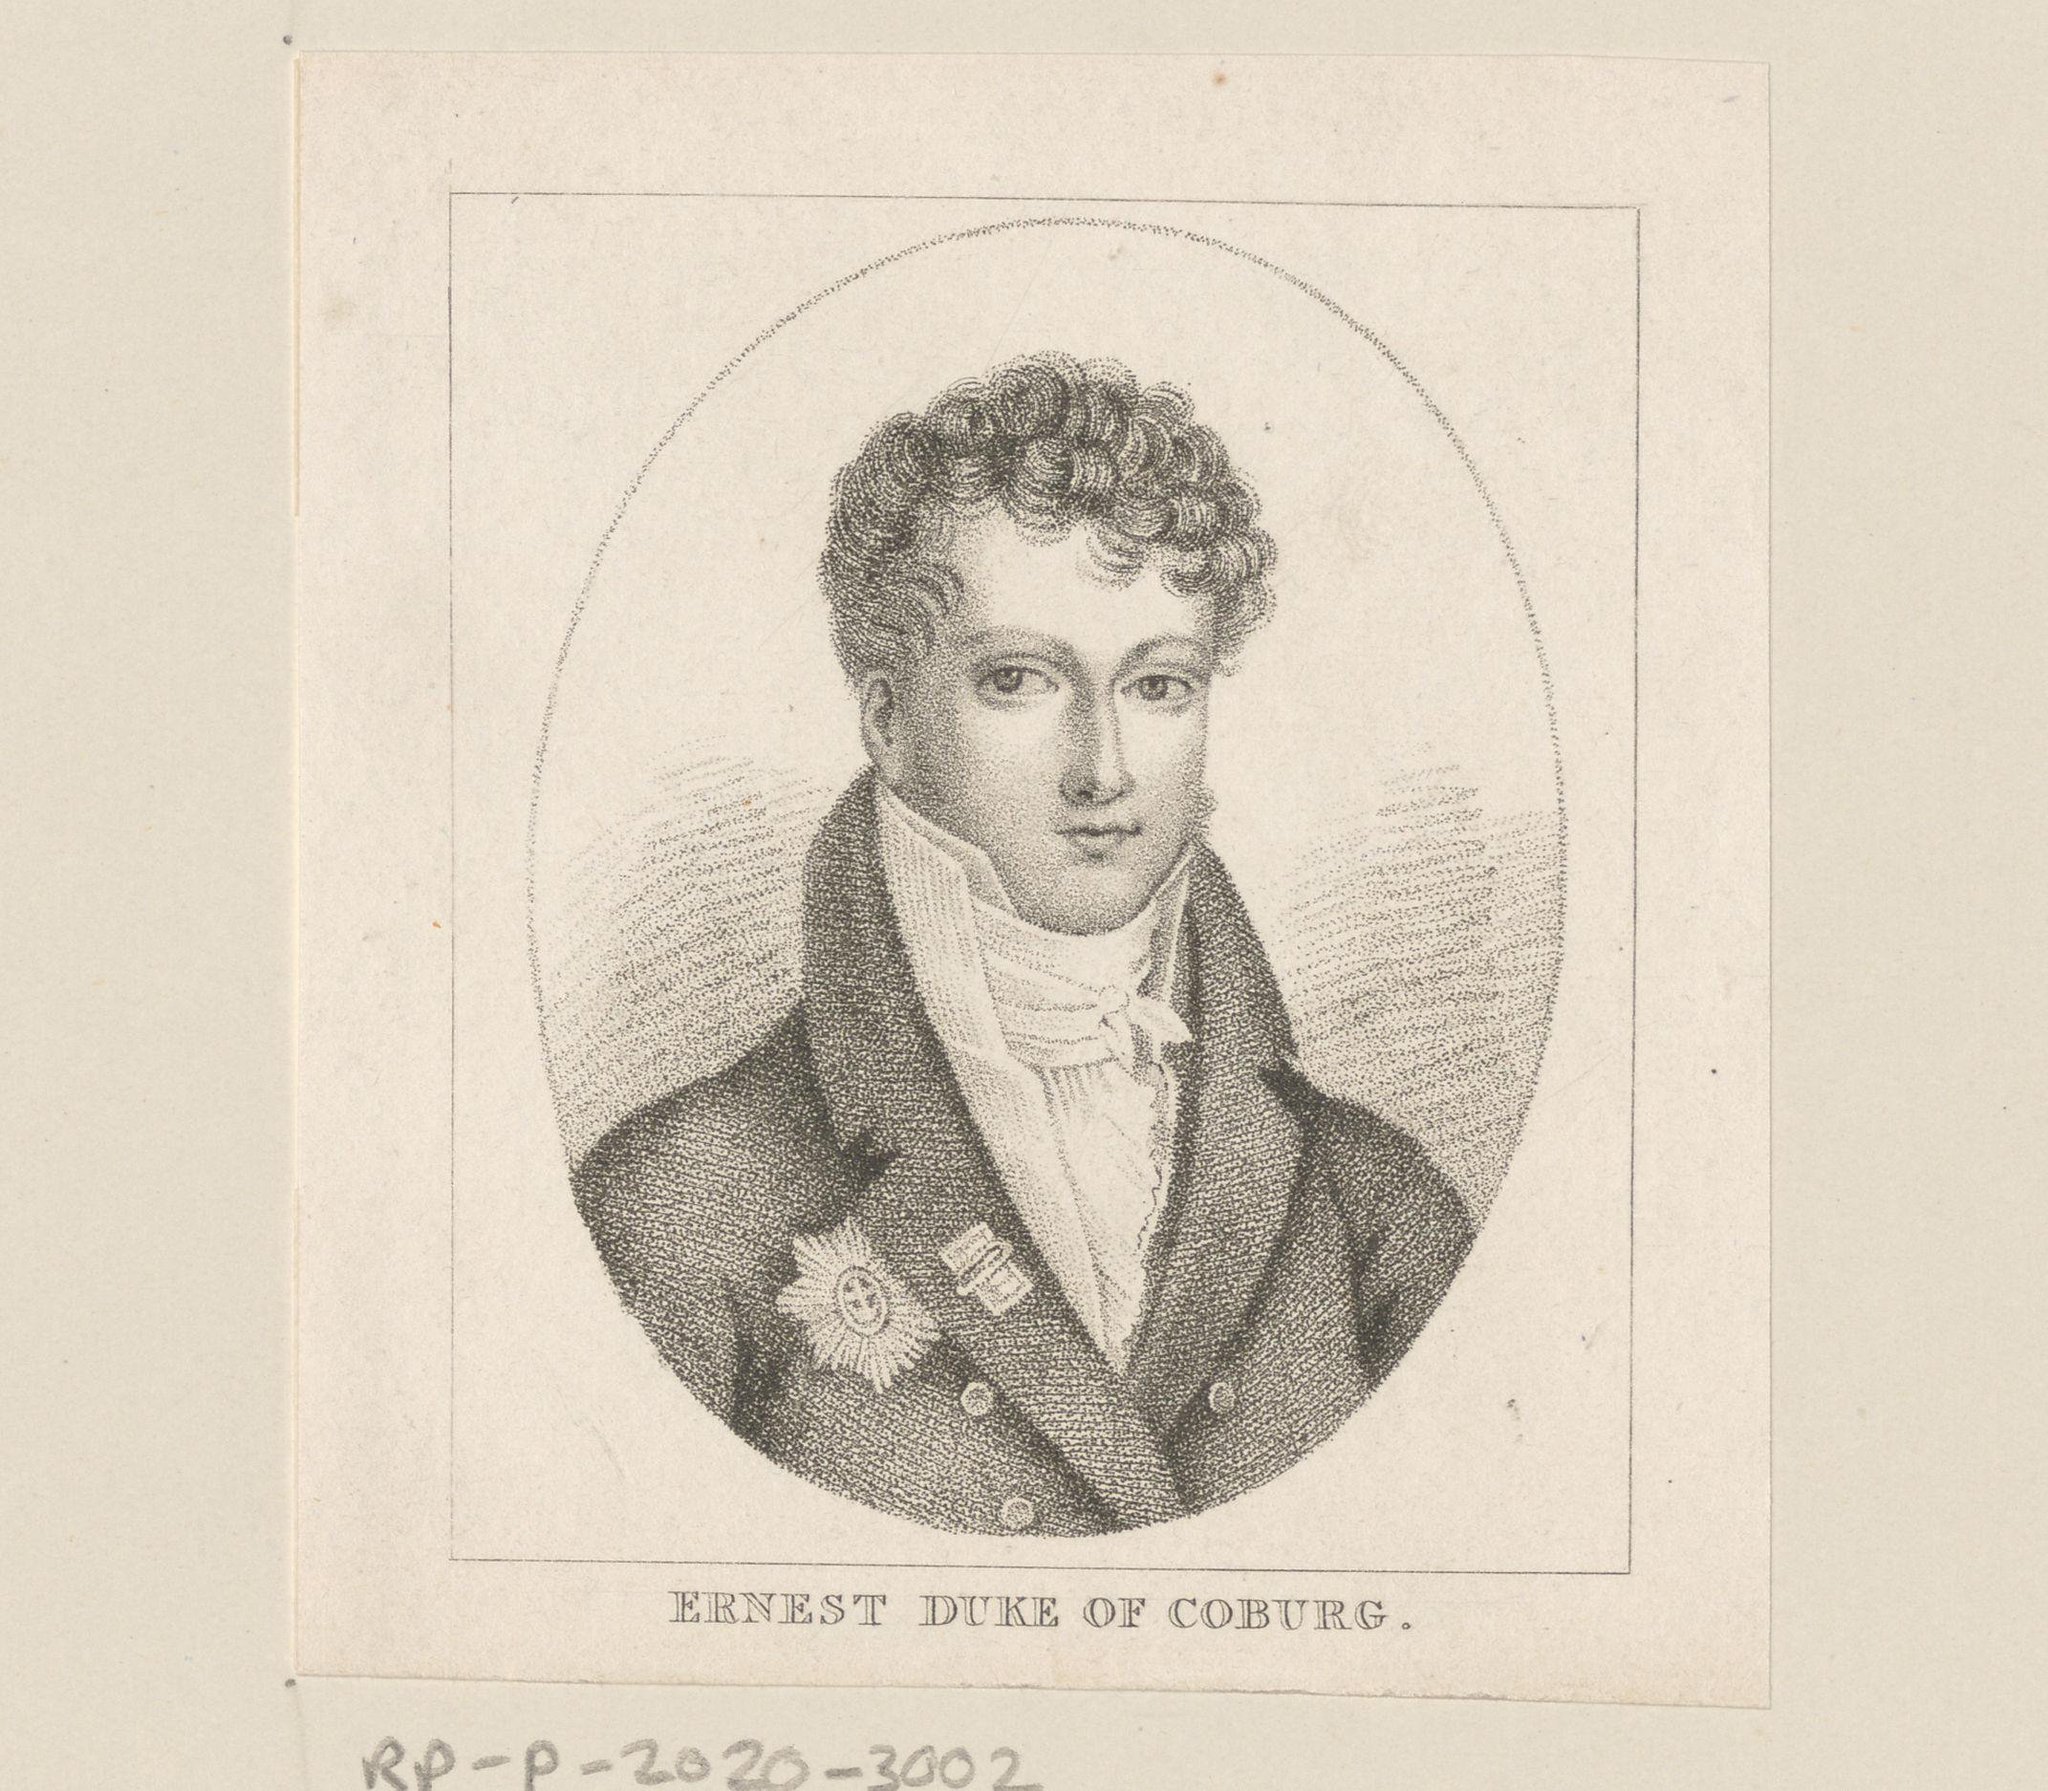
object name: print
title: Portret van Ernst I van Saksen-Coburg en Gotha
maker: Anonymous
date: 1750-1850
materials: paper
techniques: engraving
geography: england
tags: historical persons